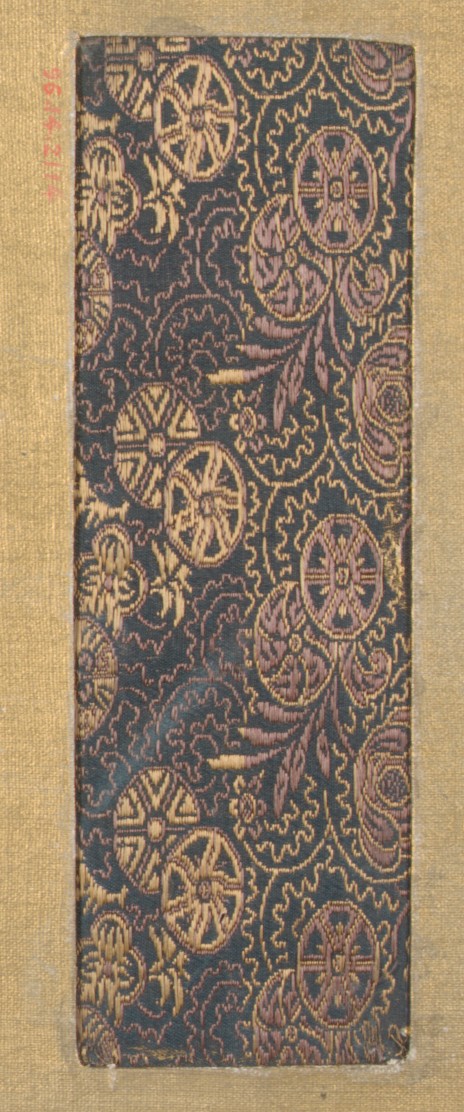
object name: piece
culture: japanese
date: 1701-1900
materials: silk